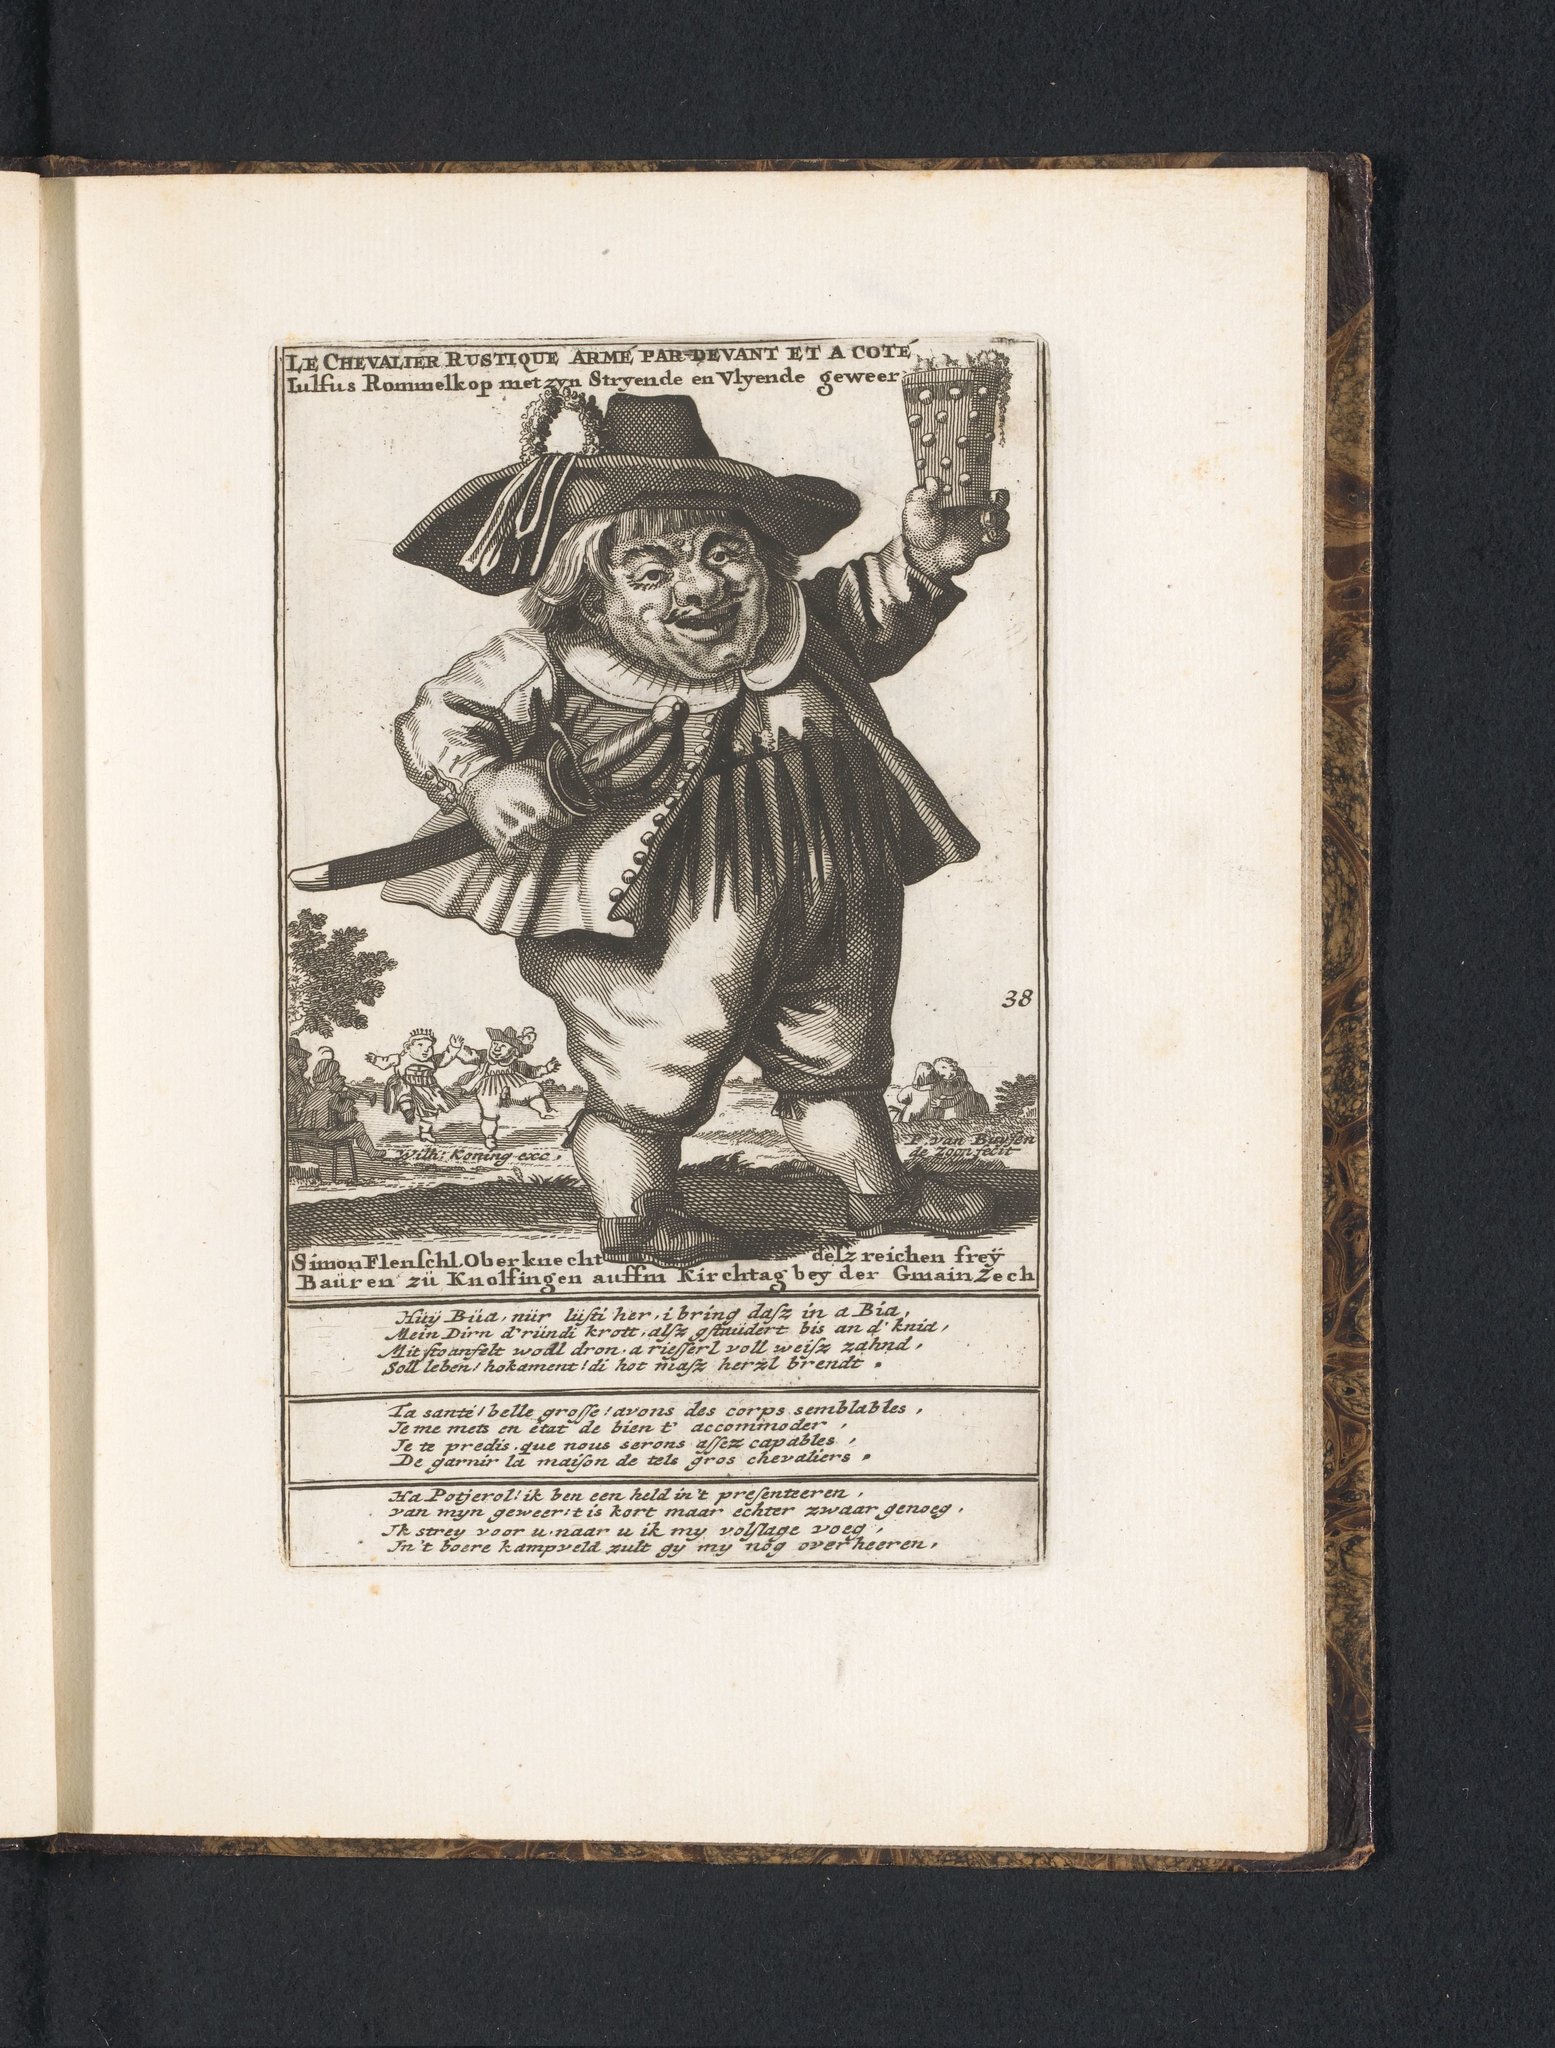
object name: print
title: Le Chevalier Rustique armé par devant et a coté / Justus Rommelkop met zyn Stryende en Vlyende geweer / Simon Flenschl, Oberknecht desz reichen frey Baüren zü Knolsingen auffm Kirchtag bey der Gmain Zech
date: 1718-1720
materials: paper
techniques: etching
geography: northern netherlands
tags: caricatures (human types), little people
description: De kleine mens Justus Rommelkop als boer met een glas bier in de hand. In het onderschrift verzen in het Duits, Frans en Nederlands. Genummerd rechts midden: 38. Onderdeel van deel II in de tweede Nederlandse gebonden uitgave uit 1720 (en gerelateerd aan de Windhandel in dat jaar) van een serie karikaturen van kleine mensen, bekend als Het Dwergentooneel.